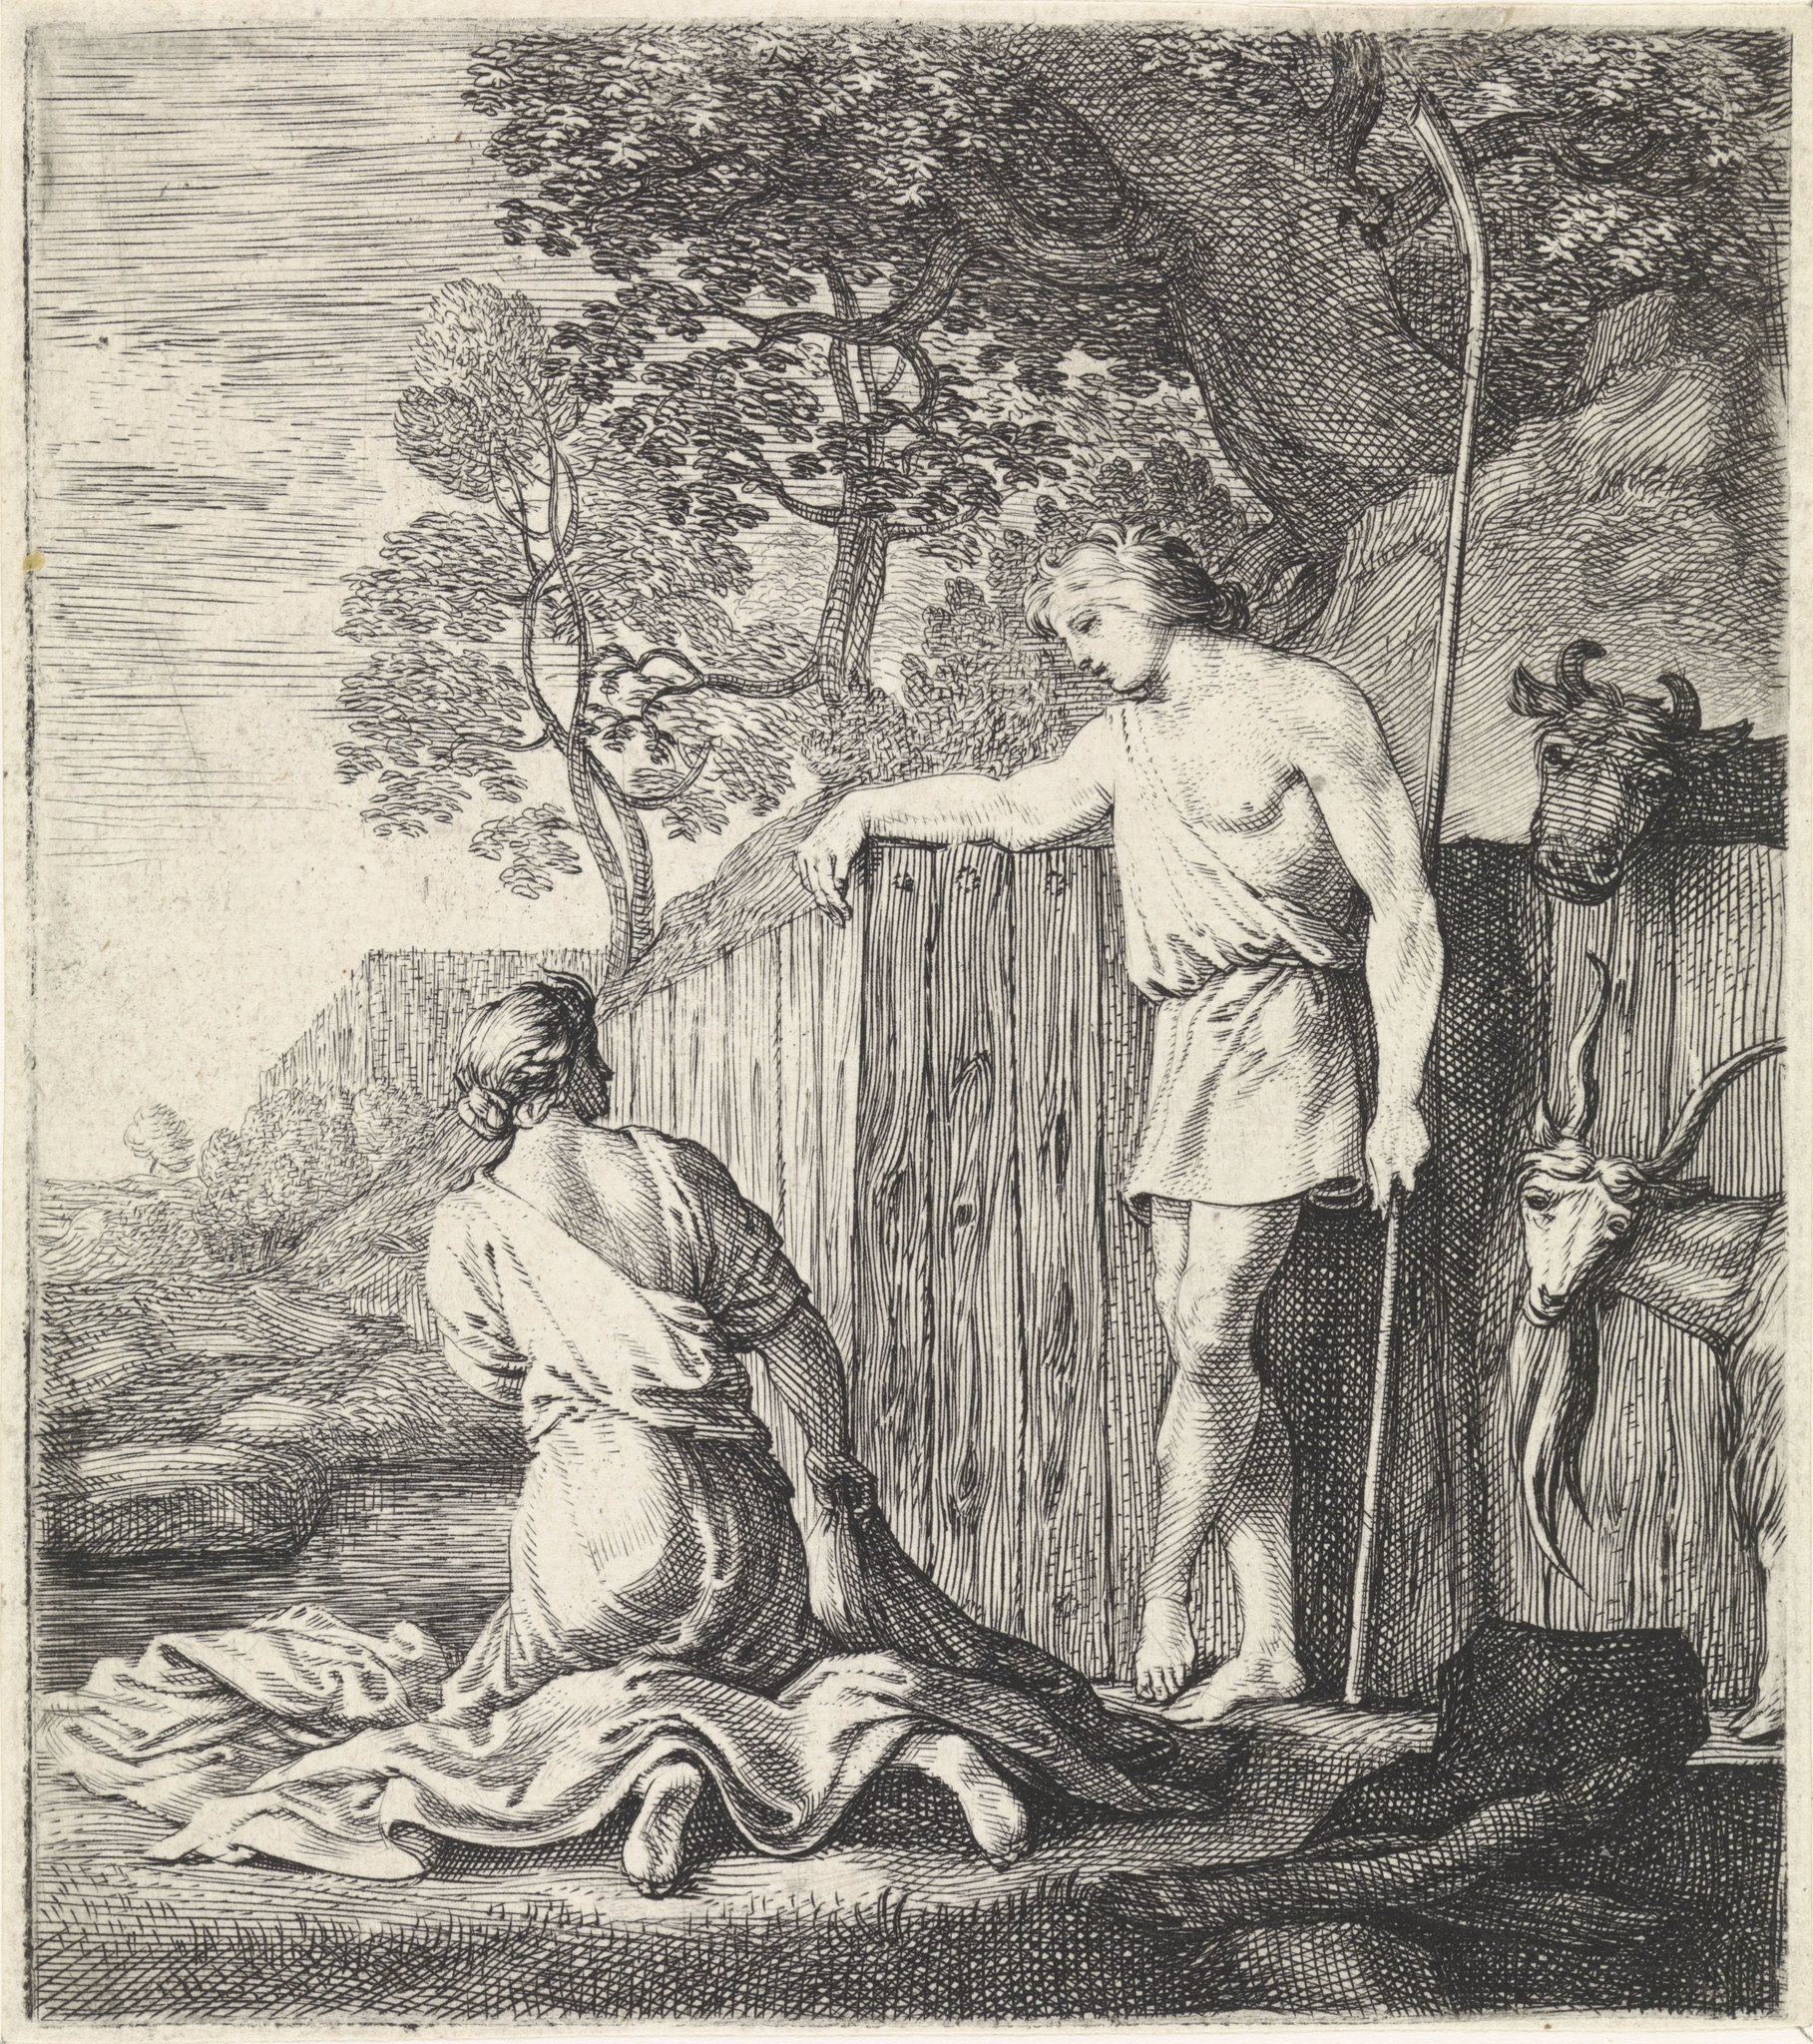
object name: print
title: Wasvrouw en herder bij een beek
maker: moyses van wtenbrouck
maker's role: painter, print maker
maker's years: 1590-1647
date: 1600-1647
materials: paper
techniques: engraving, etching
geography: the hague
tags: herding, herdsman, herdswoman, shepherd, shepherdess, cowherd, etc., laundering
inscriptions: collector's mark: Lugt 240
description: Een wasvrouw zit geknield bij een beek en kijkt op naar een herder, die een herdersstaf in zijn hand houdt.